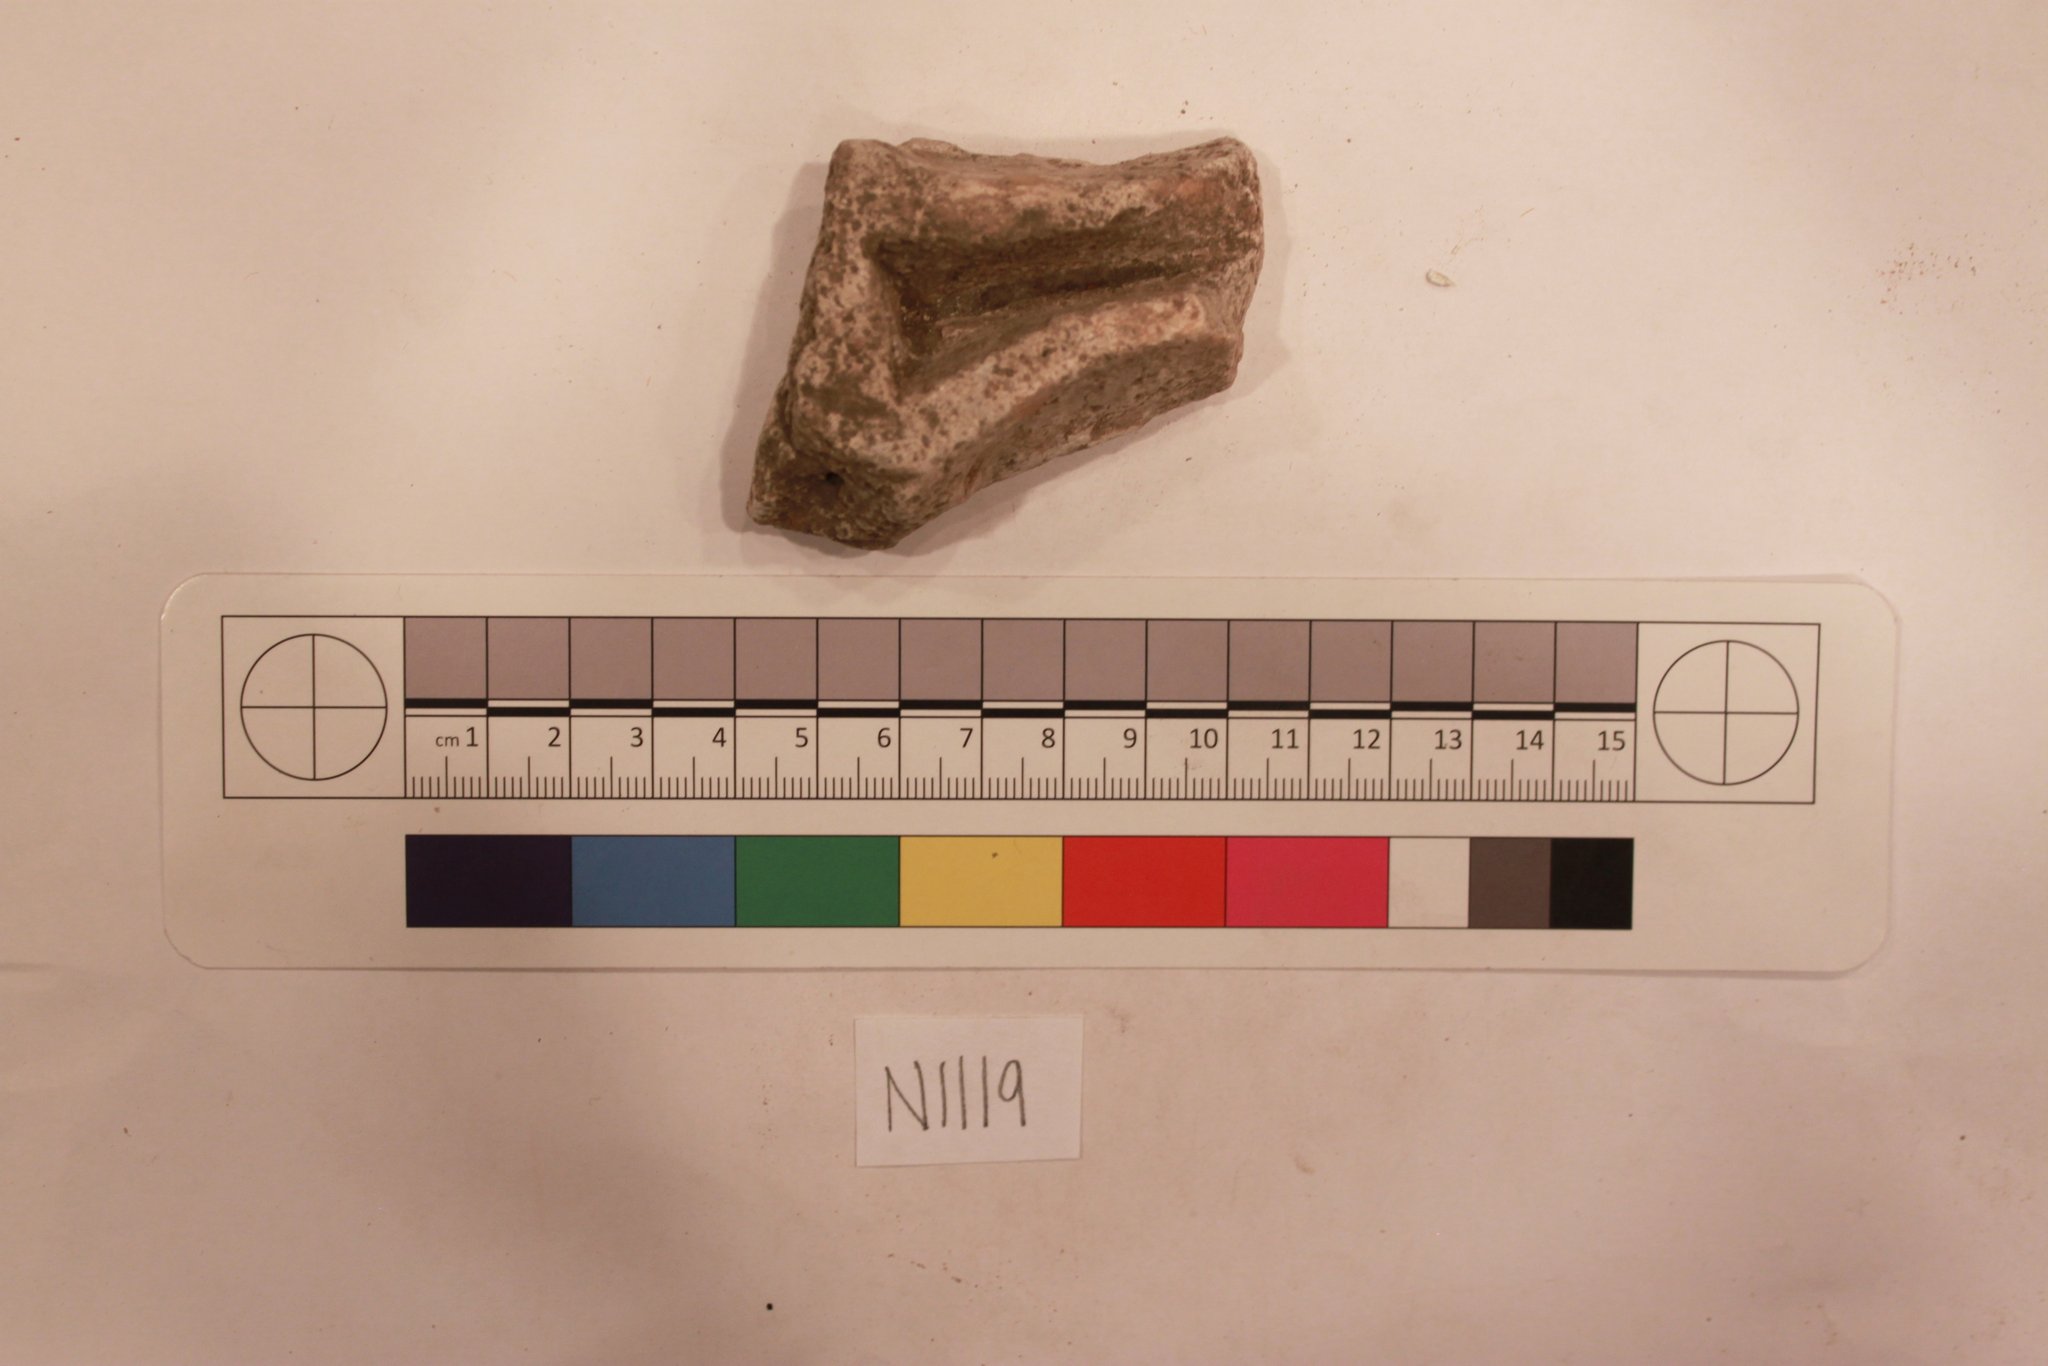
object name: fragment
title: Stucco Fragment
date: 701-1200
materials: plaster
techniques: carving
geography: iran